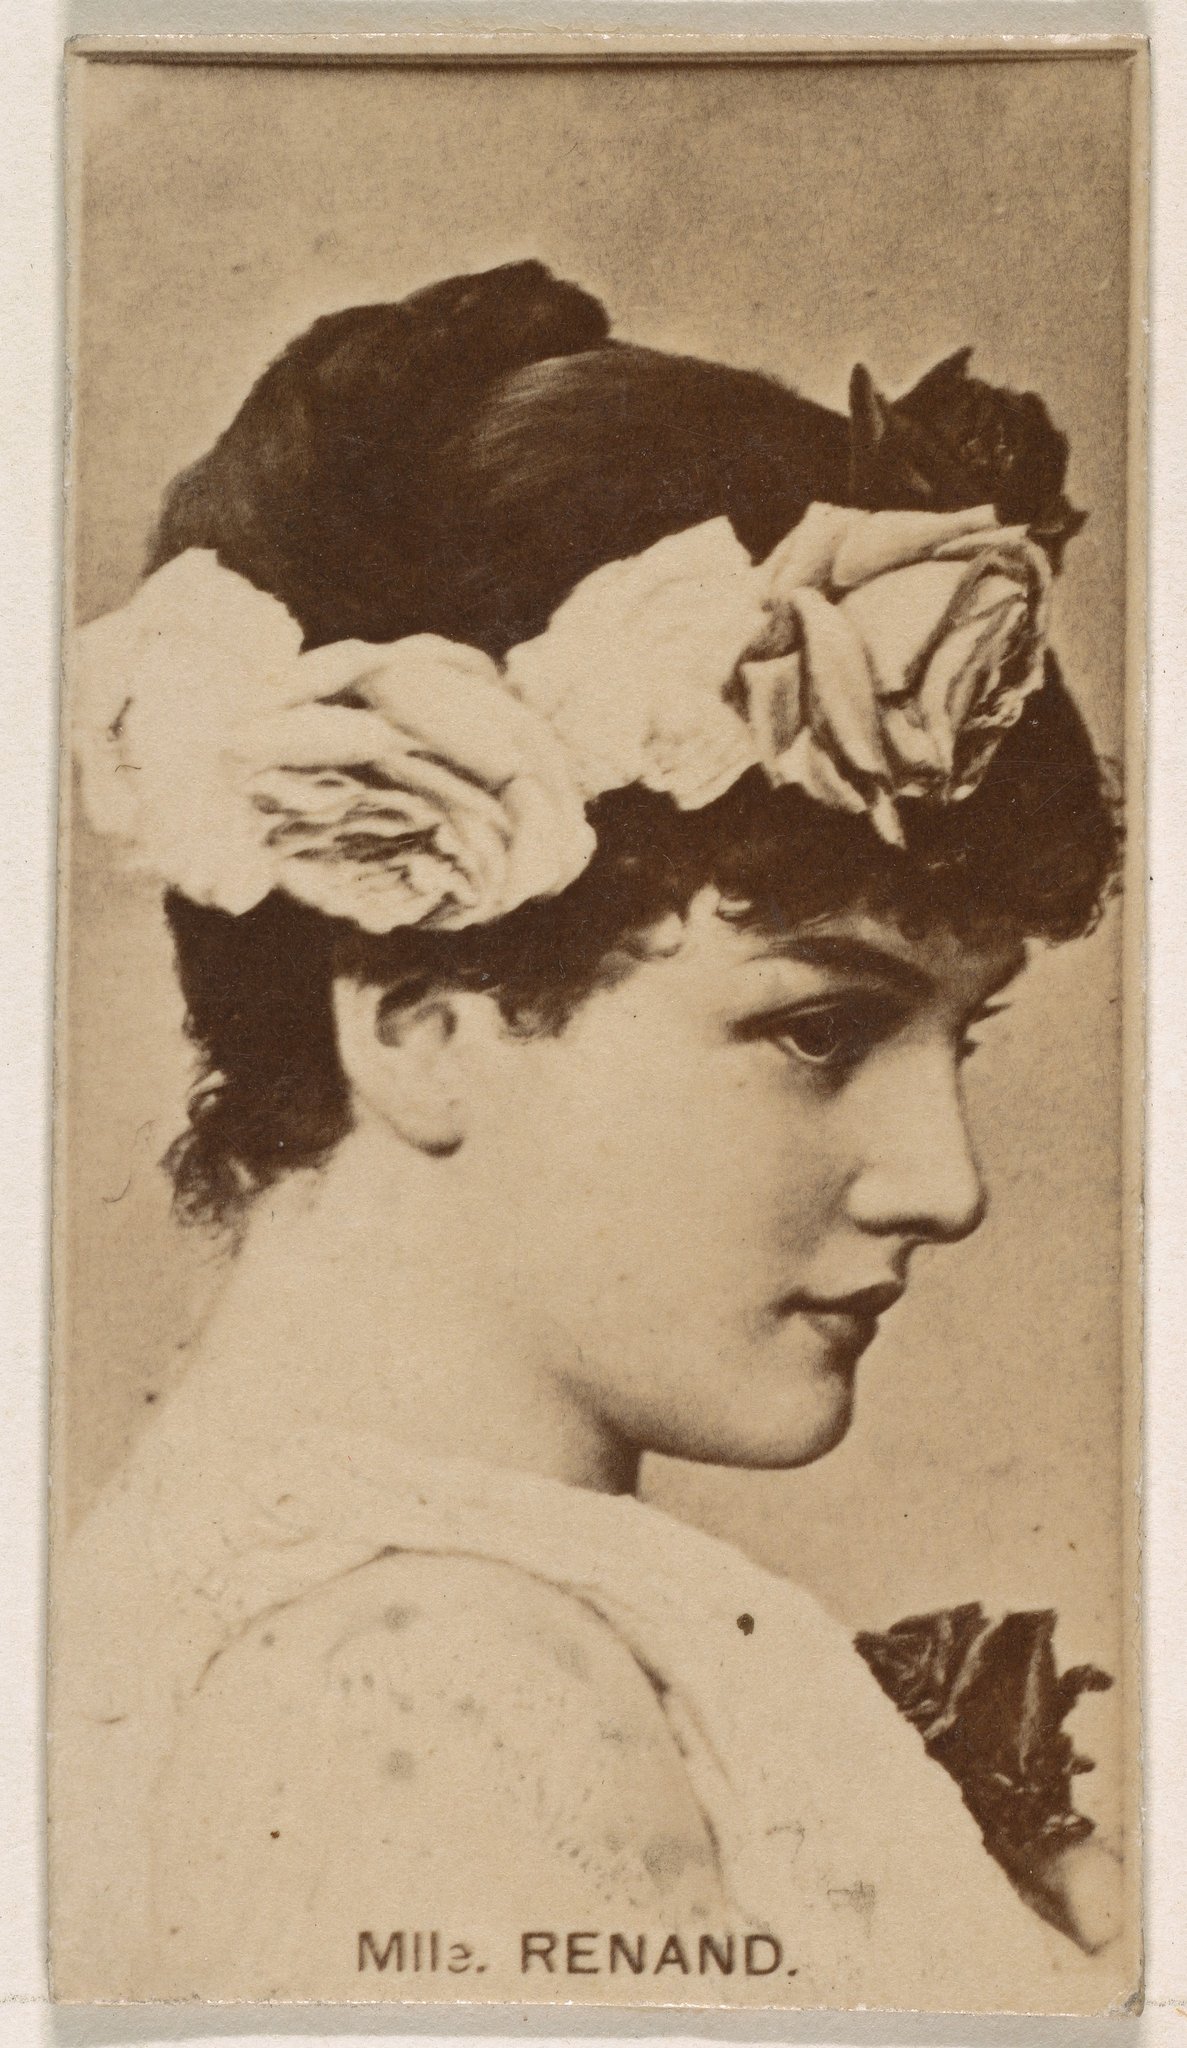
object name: photograph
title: Mlle. Renand, from the Actresses series (N245) issued by Kinney Brothers to promote Sweet Caporal Cigarettes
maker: kinney brothers tobacco company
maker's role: publisher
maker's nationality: american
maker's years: 1869-2011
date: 1890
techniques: albumen silver print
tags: women,actresses